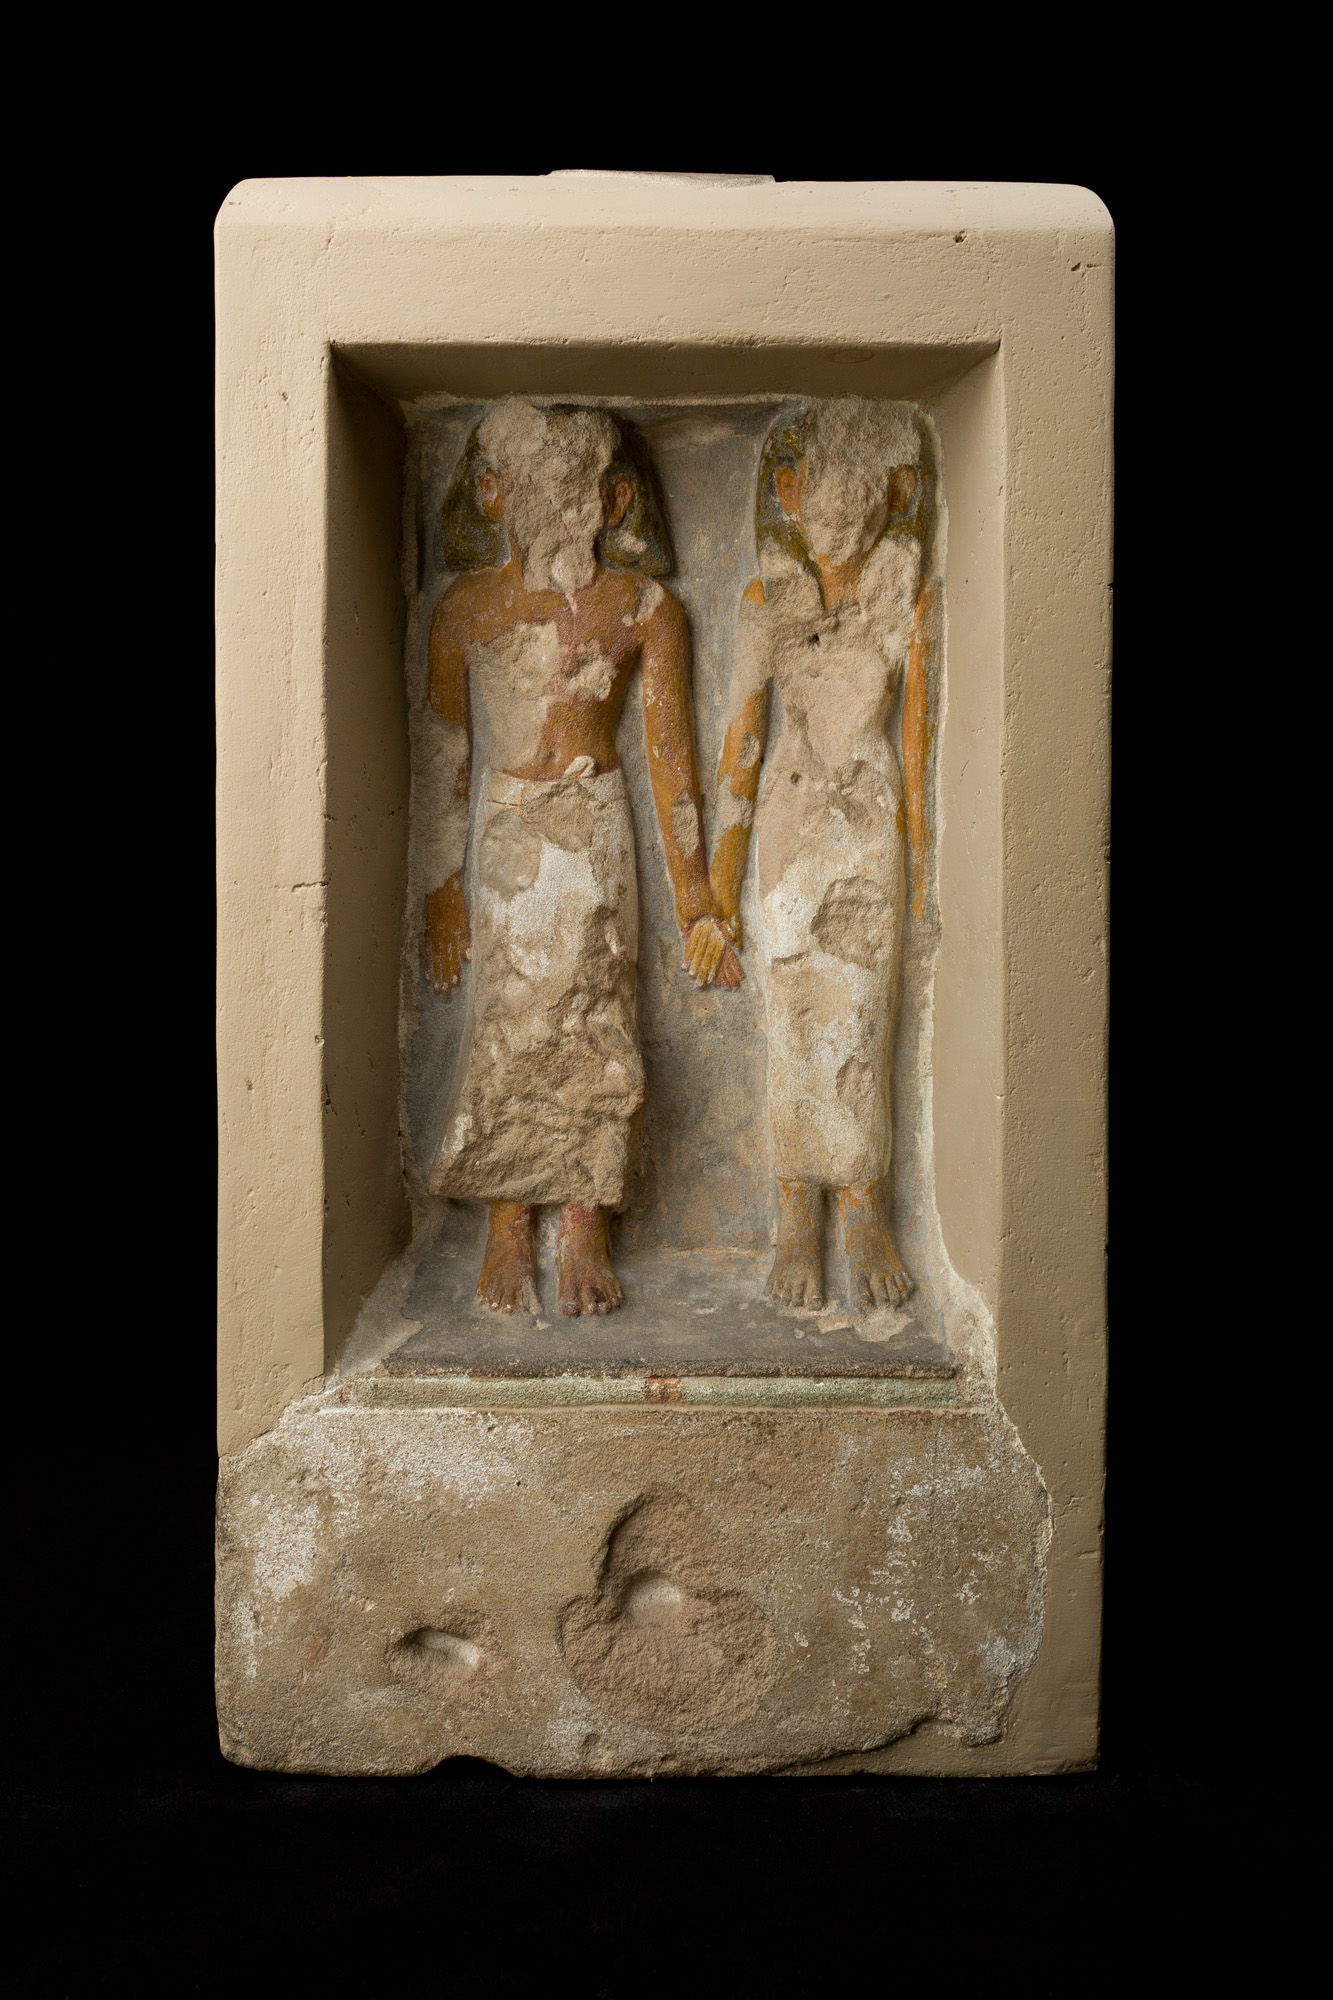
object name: shrine, statue, ipunefer, aashyt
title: Shrine with statues and relief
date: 1550-1450 BCE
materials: paint, stone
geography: egypt